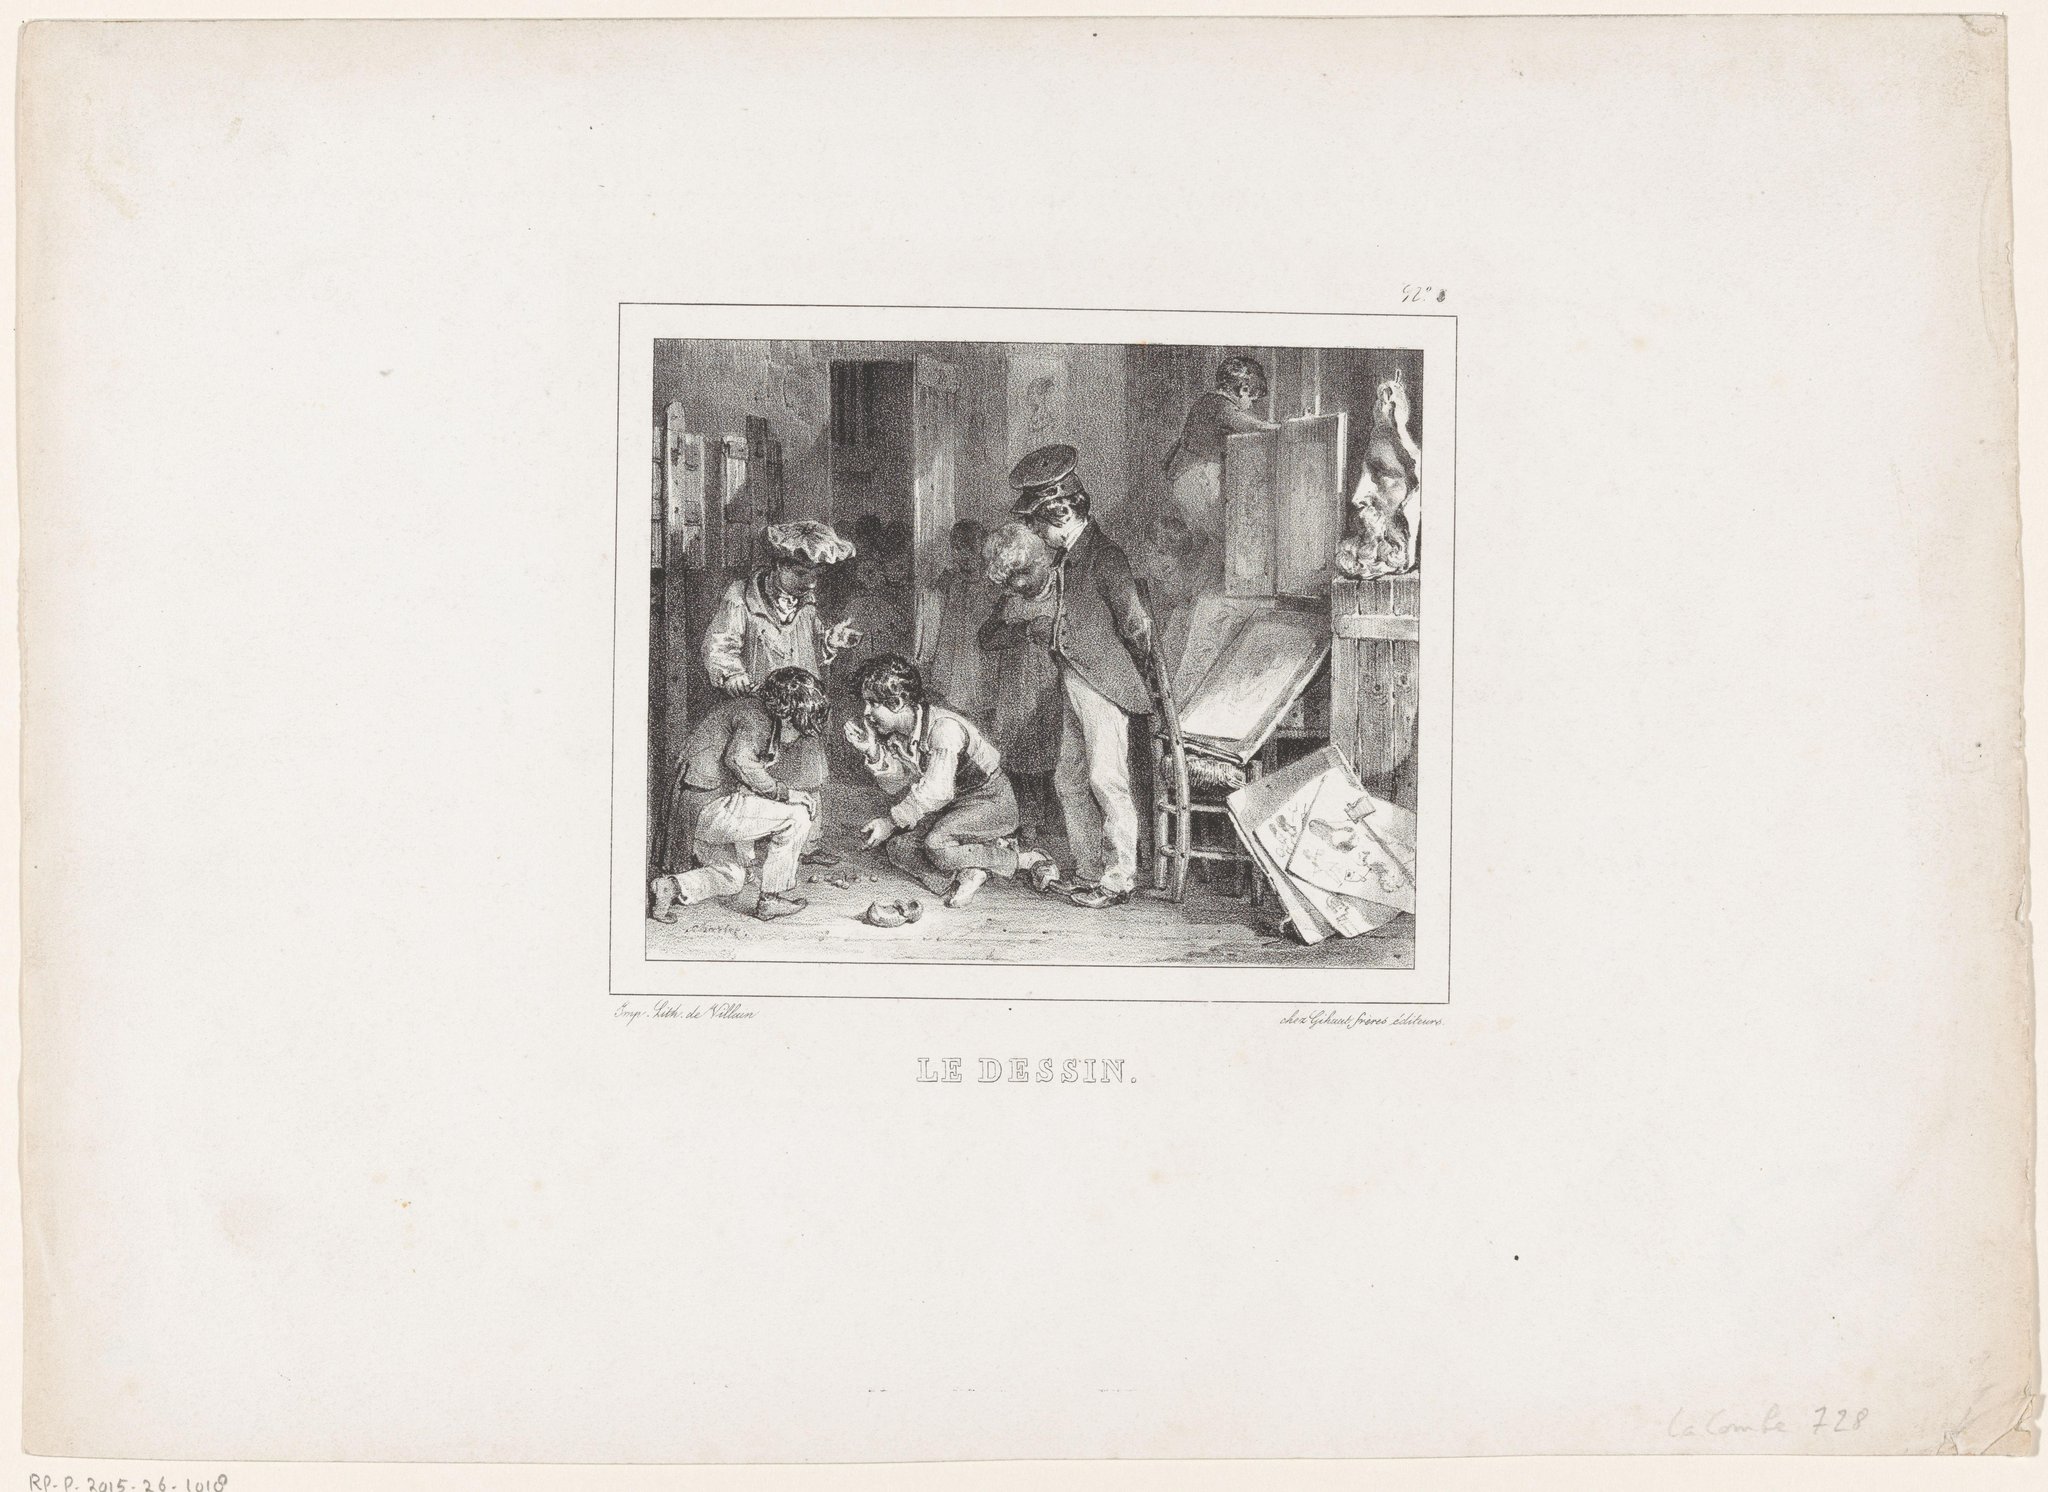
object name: print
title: Album lithographique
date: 1829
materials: paper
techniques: lithograph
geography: paris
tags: games using special objects (marbles, top, hoop, etc.)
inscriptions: collector's mark: Lugt 2228, collector's mark